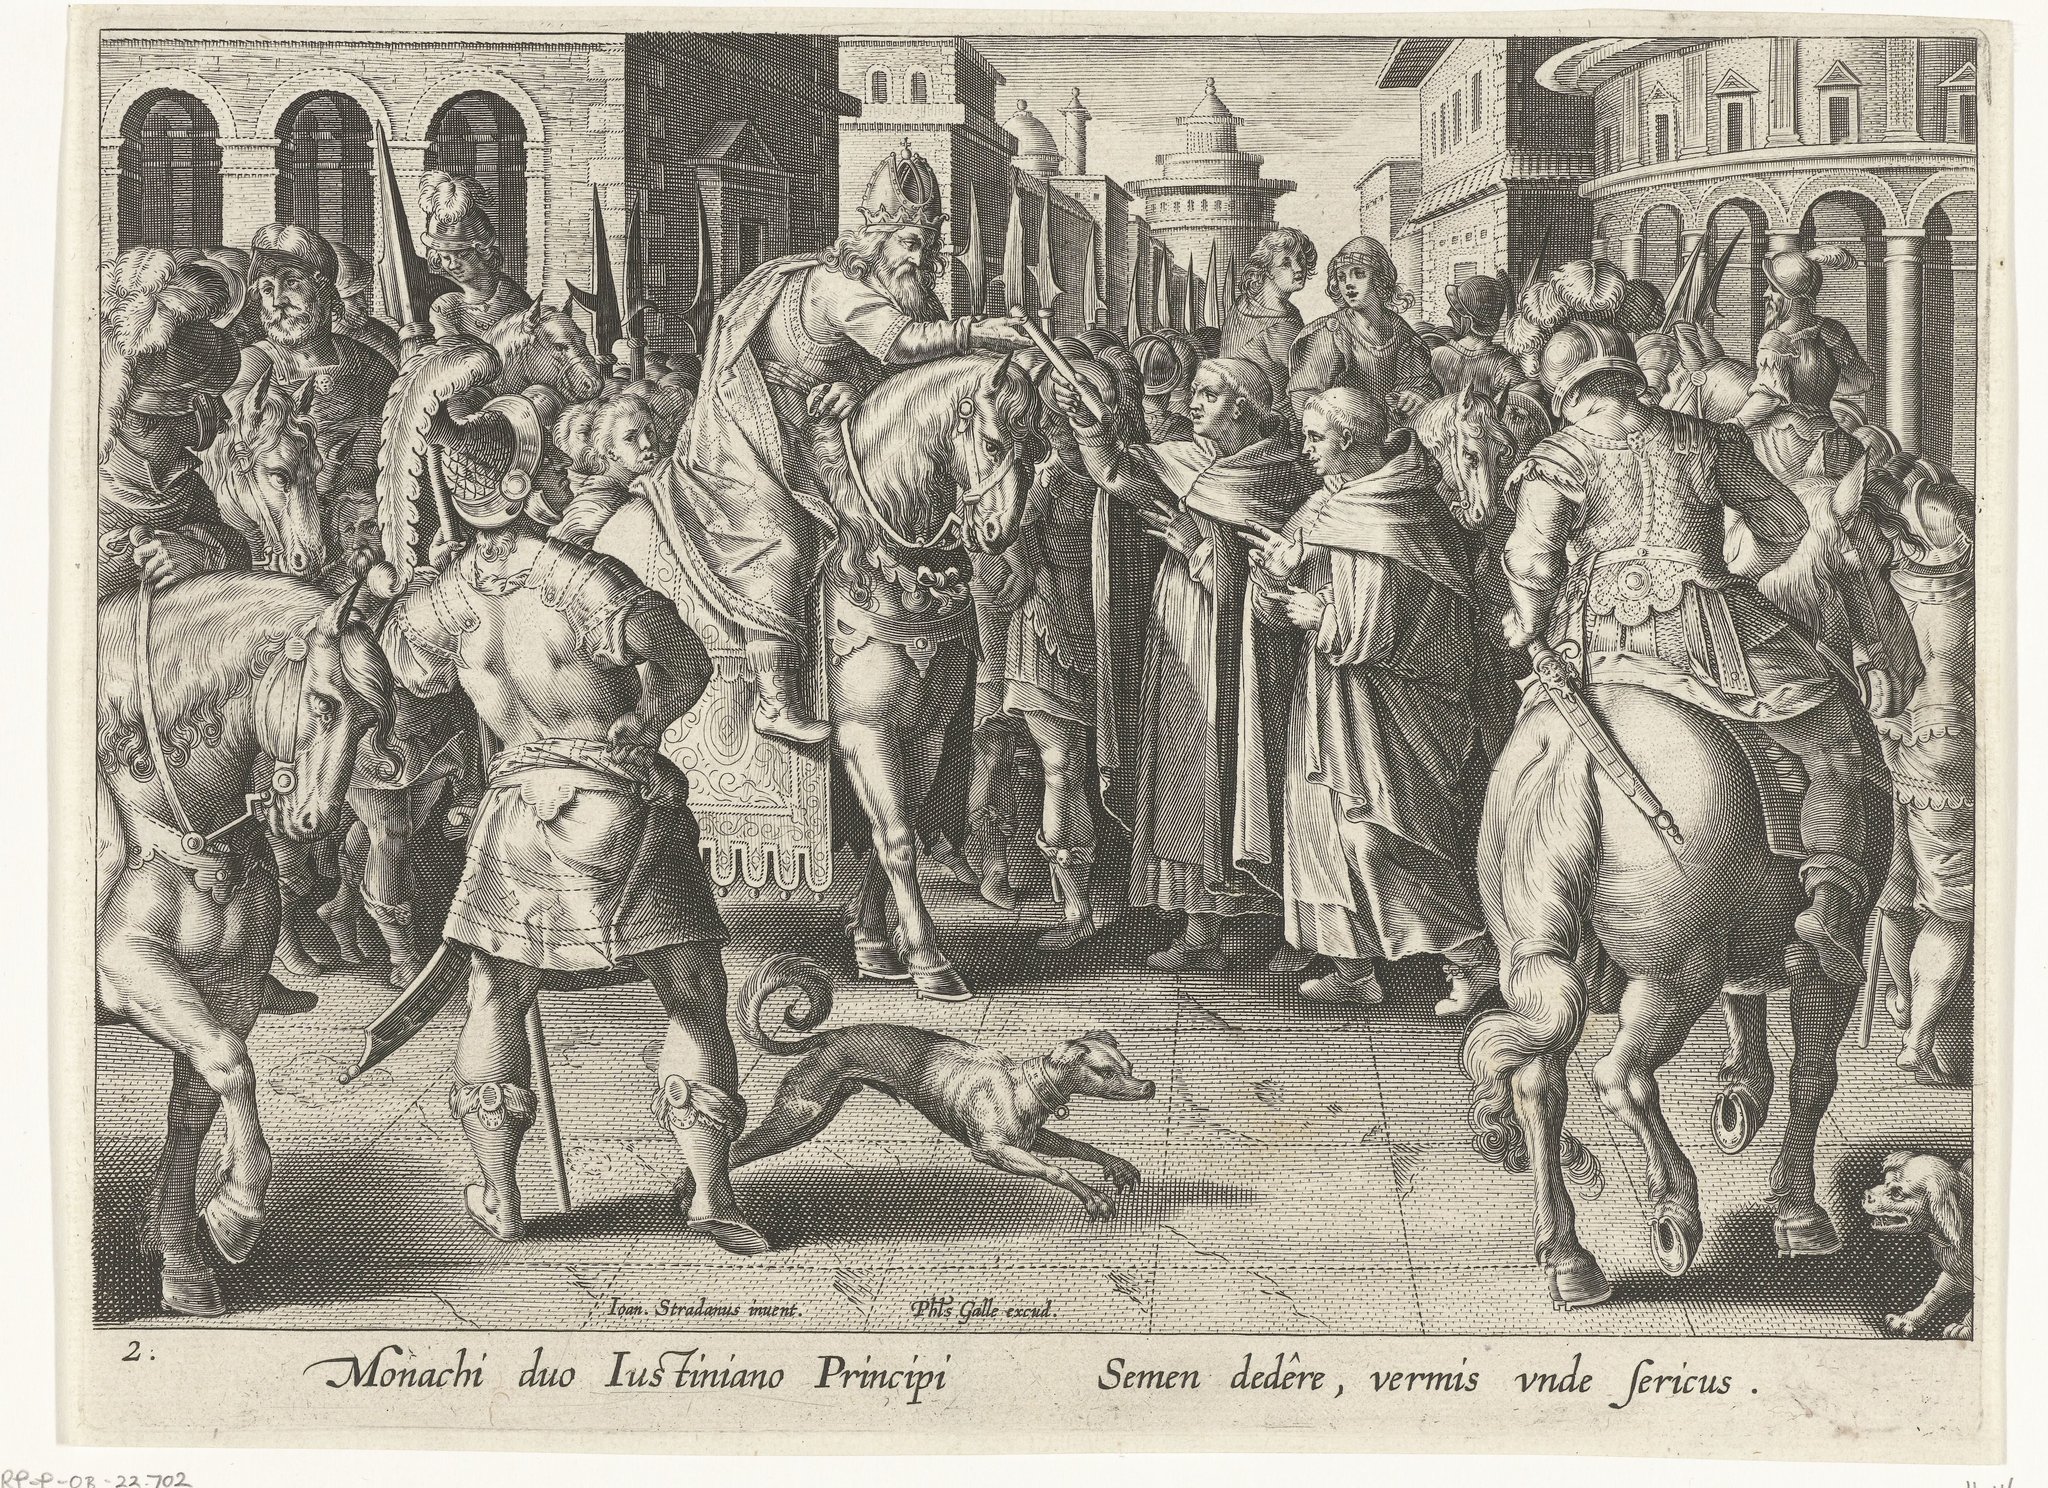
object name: print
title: Keizer Justinianus I ontvangt de eerste zijdewormeitjes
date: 1595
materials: paper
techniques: engraving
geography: antwerp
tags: special processes for silk fabric, silkworm, silk (material ~ textile industry)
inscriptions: collector's mark: Lugt 240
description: Keizer Justinianus I ontvangt de eerste zijdewormeitjes van Nestoriaanse monniken. Onderaan twee regels in het Latijn. Tweede prent van een serie van zes prenten over de introductie van de zijderups en de zijdeproductie in Europa.